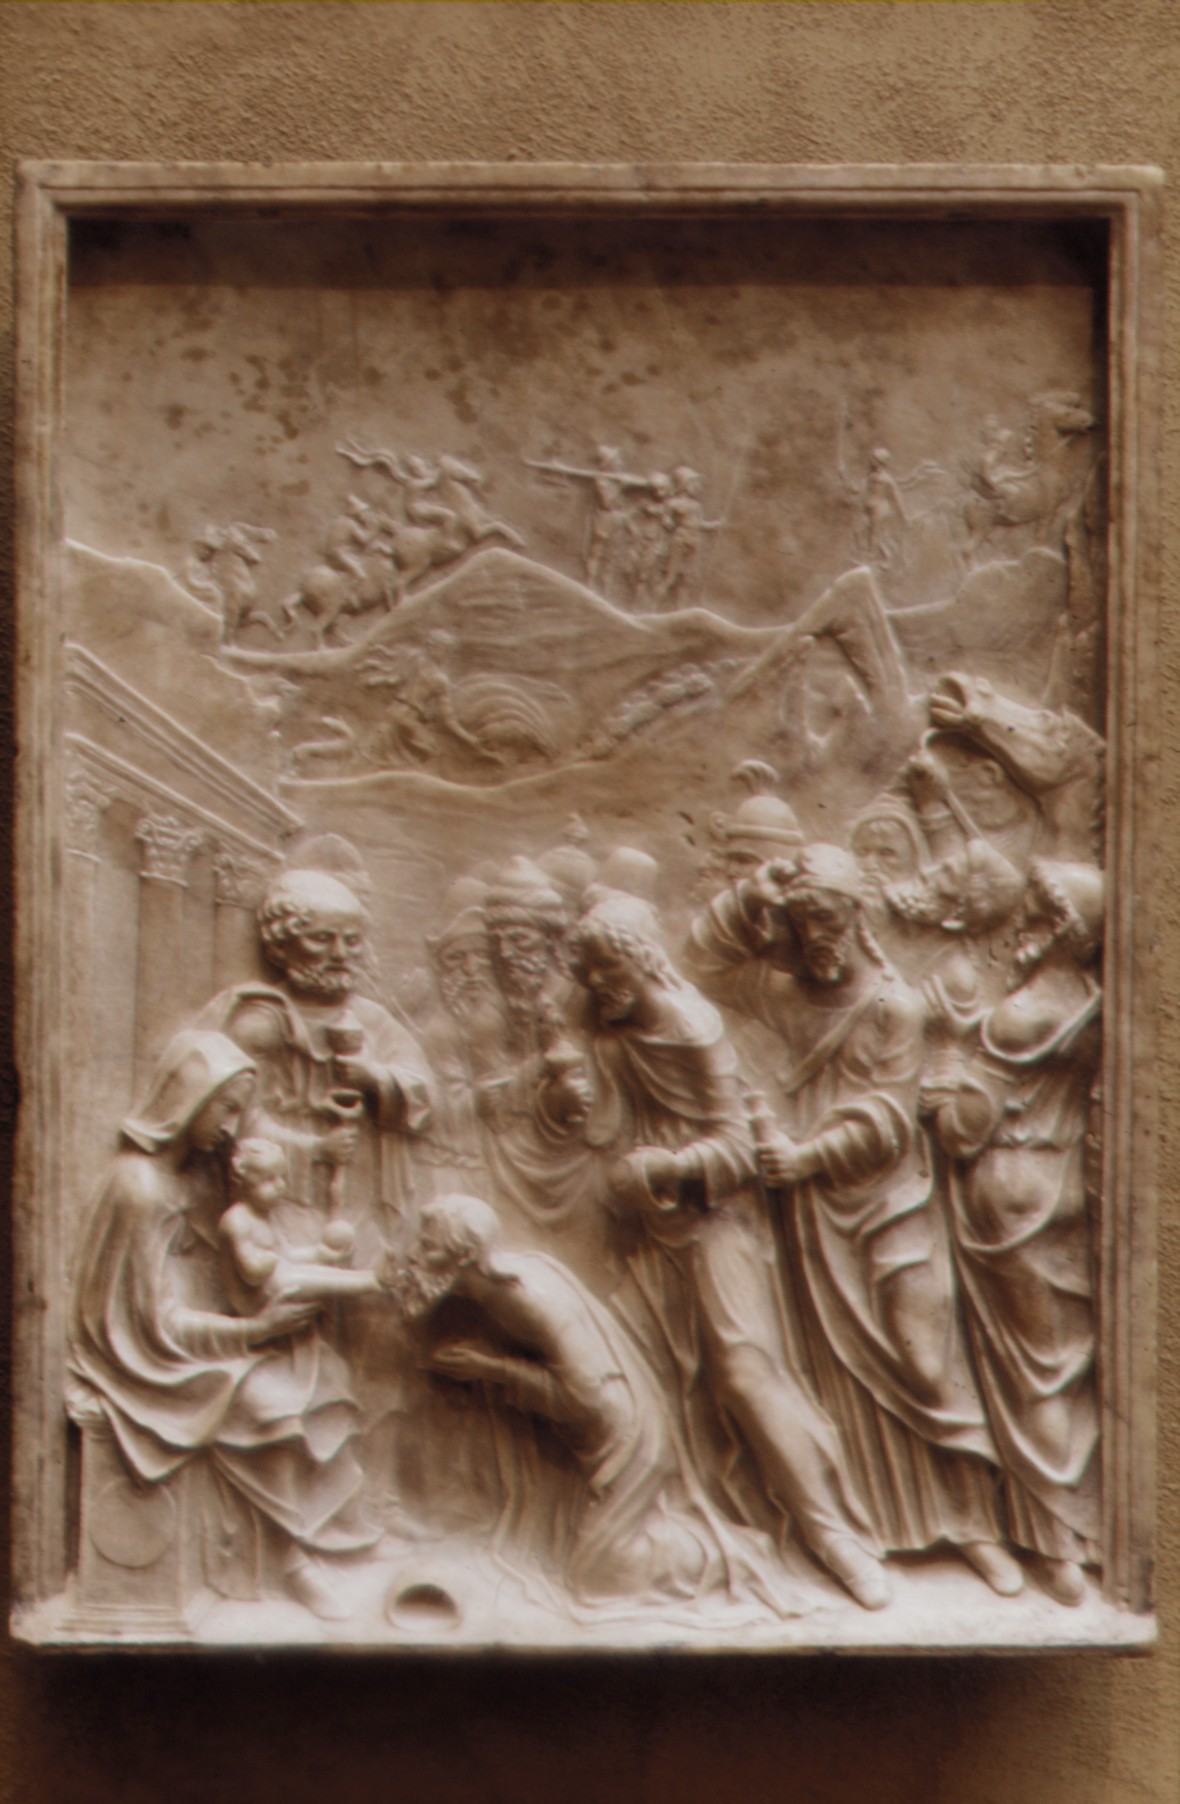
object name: relief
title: Adoration of the Magi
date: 1510-1520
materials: marble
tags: human figures,virgin mary,jesus,adoration of the magi